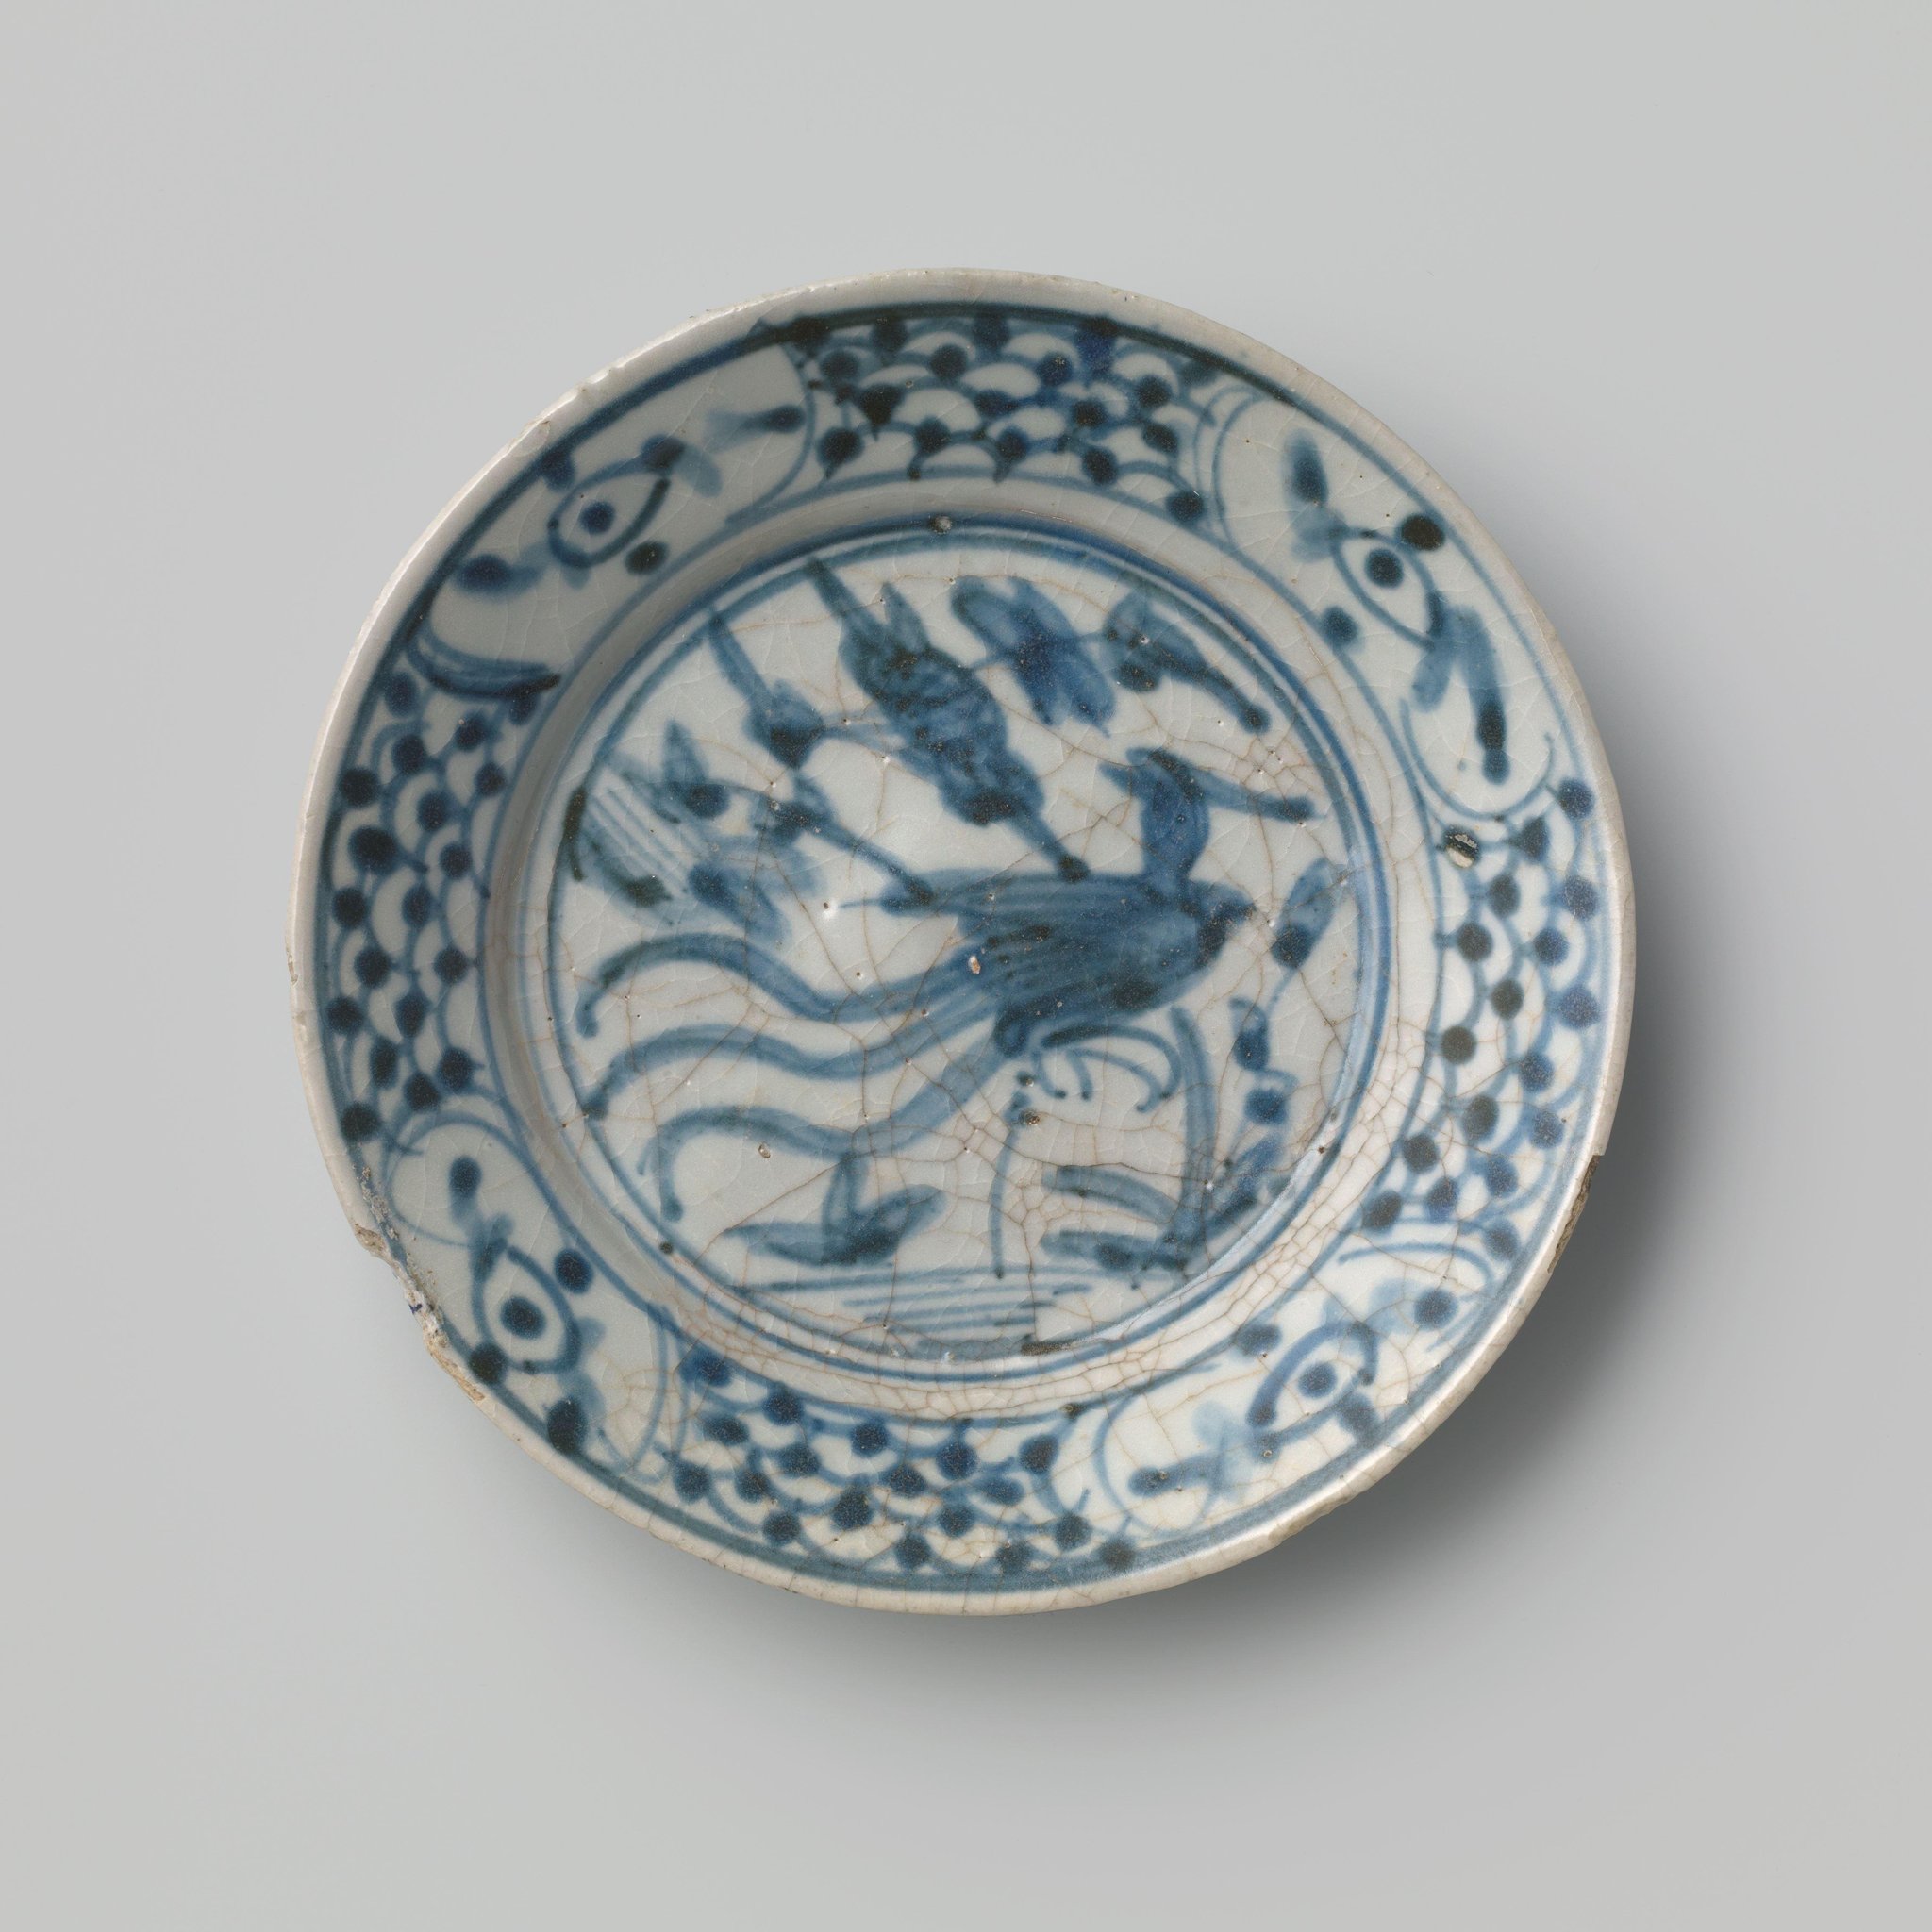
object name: plate dish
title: Bord uit V.O.C.-schip de 'Witte Leeuw'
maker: Anonymous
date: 1613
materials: glaze, porcelain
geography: swatow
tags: verenigde oostindische compagnie, sint-helena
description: A dish. In the centre is a horizontally standing bird on one leg among floral scrolls. Around the centre is an undecorated band. On the flaring rim are four medallions each with a sketchily drawn design. The area in between is filled up with fish scale pattern. On the outside are three horizontally drawn bands. There are six identical dishes.